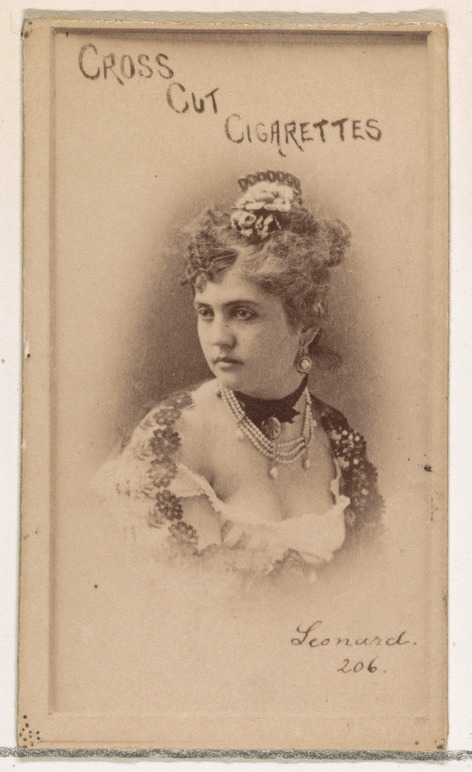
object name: print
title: Card Number 206, Leicester, from the Actors and Actresses series (N145-1) issued by Duke Sons & Co. to promote Cross Cut Cigarettes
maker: w. duke, sons & co.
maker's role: publisher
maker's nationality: american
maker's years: 1870-1920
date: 1880-1889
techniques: albumen silver print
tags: portraits,women,actresses